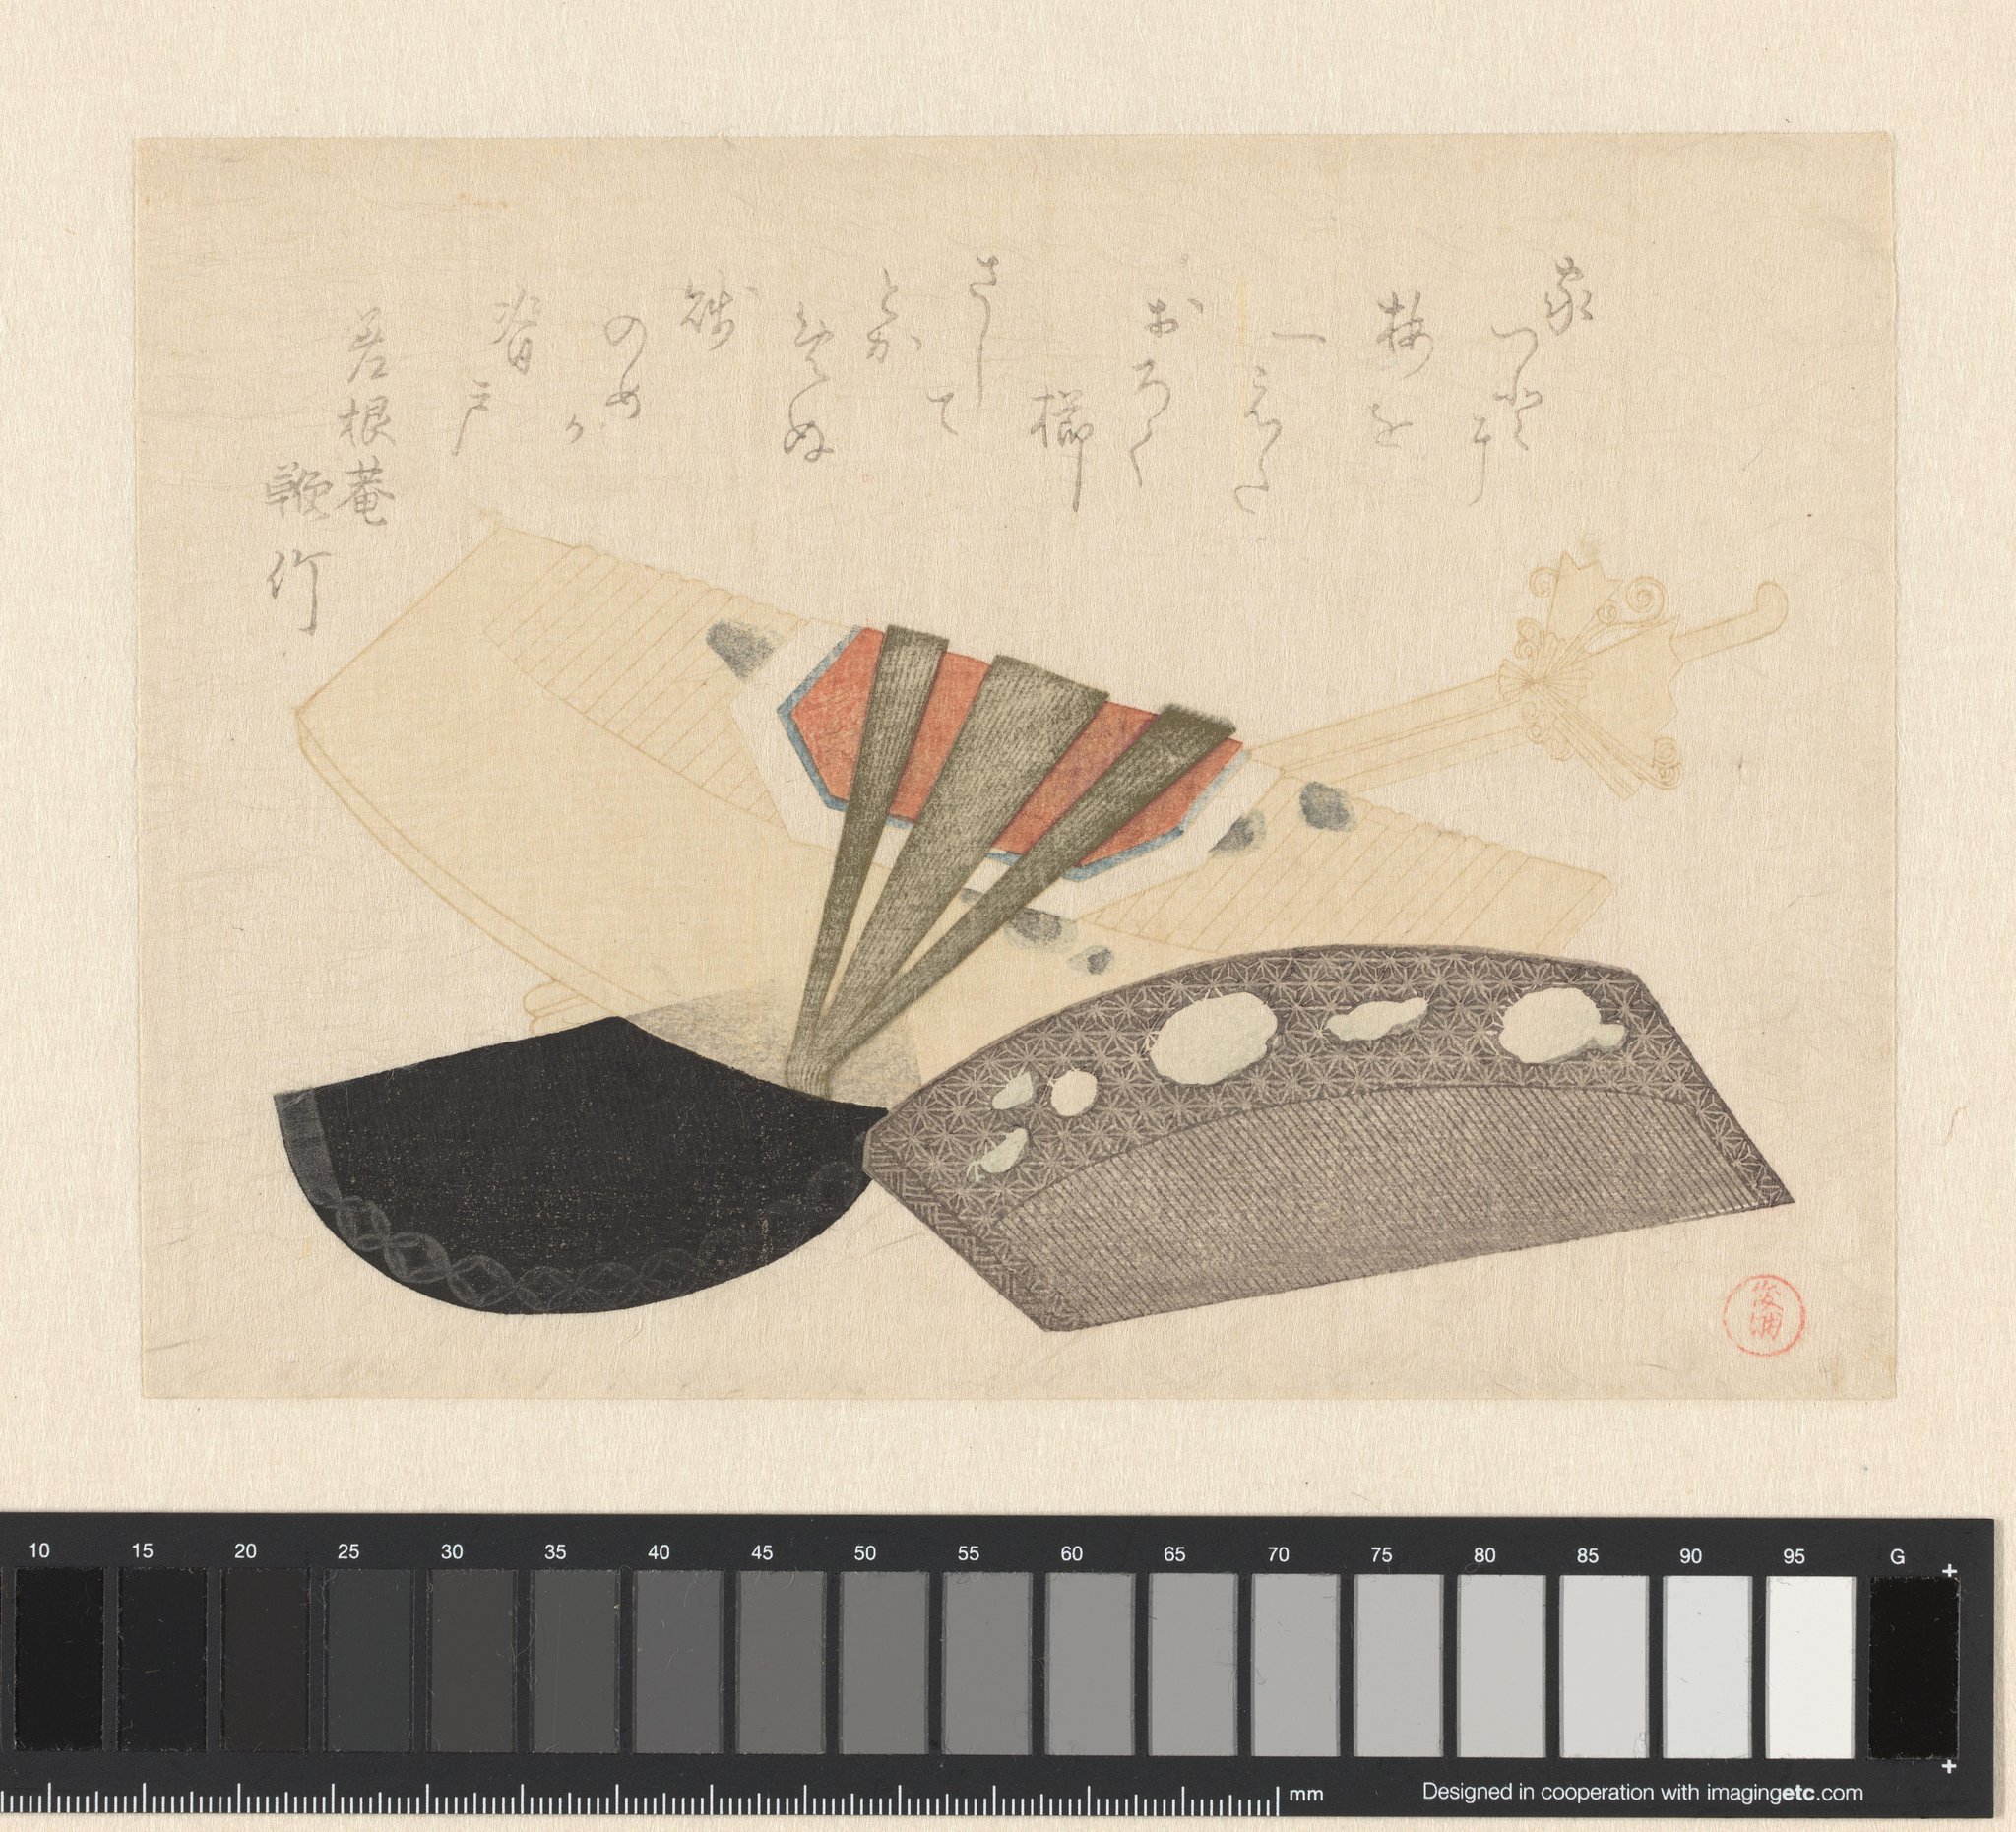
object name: surimono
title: Still Life with Combs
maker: kubota shunman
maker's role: print maker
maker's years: 1757-1820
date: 1820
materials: paper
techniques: woodcut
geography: japan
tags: comb, brush and other tools (care of the hair), still life of miscellaneous objects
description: Looking closely at this print, you can see just how cleverly it is made. The woodcutter and the printer ensured that you can discern exactly what kind of material the hair accessories are made of. In the foreground is an ebony comb inlaid with ivory cherry blossom; behind it is a transparent tortoiseshell comb; and below that a black lacquer comb and an ivory hairpin.